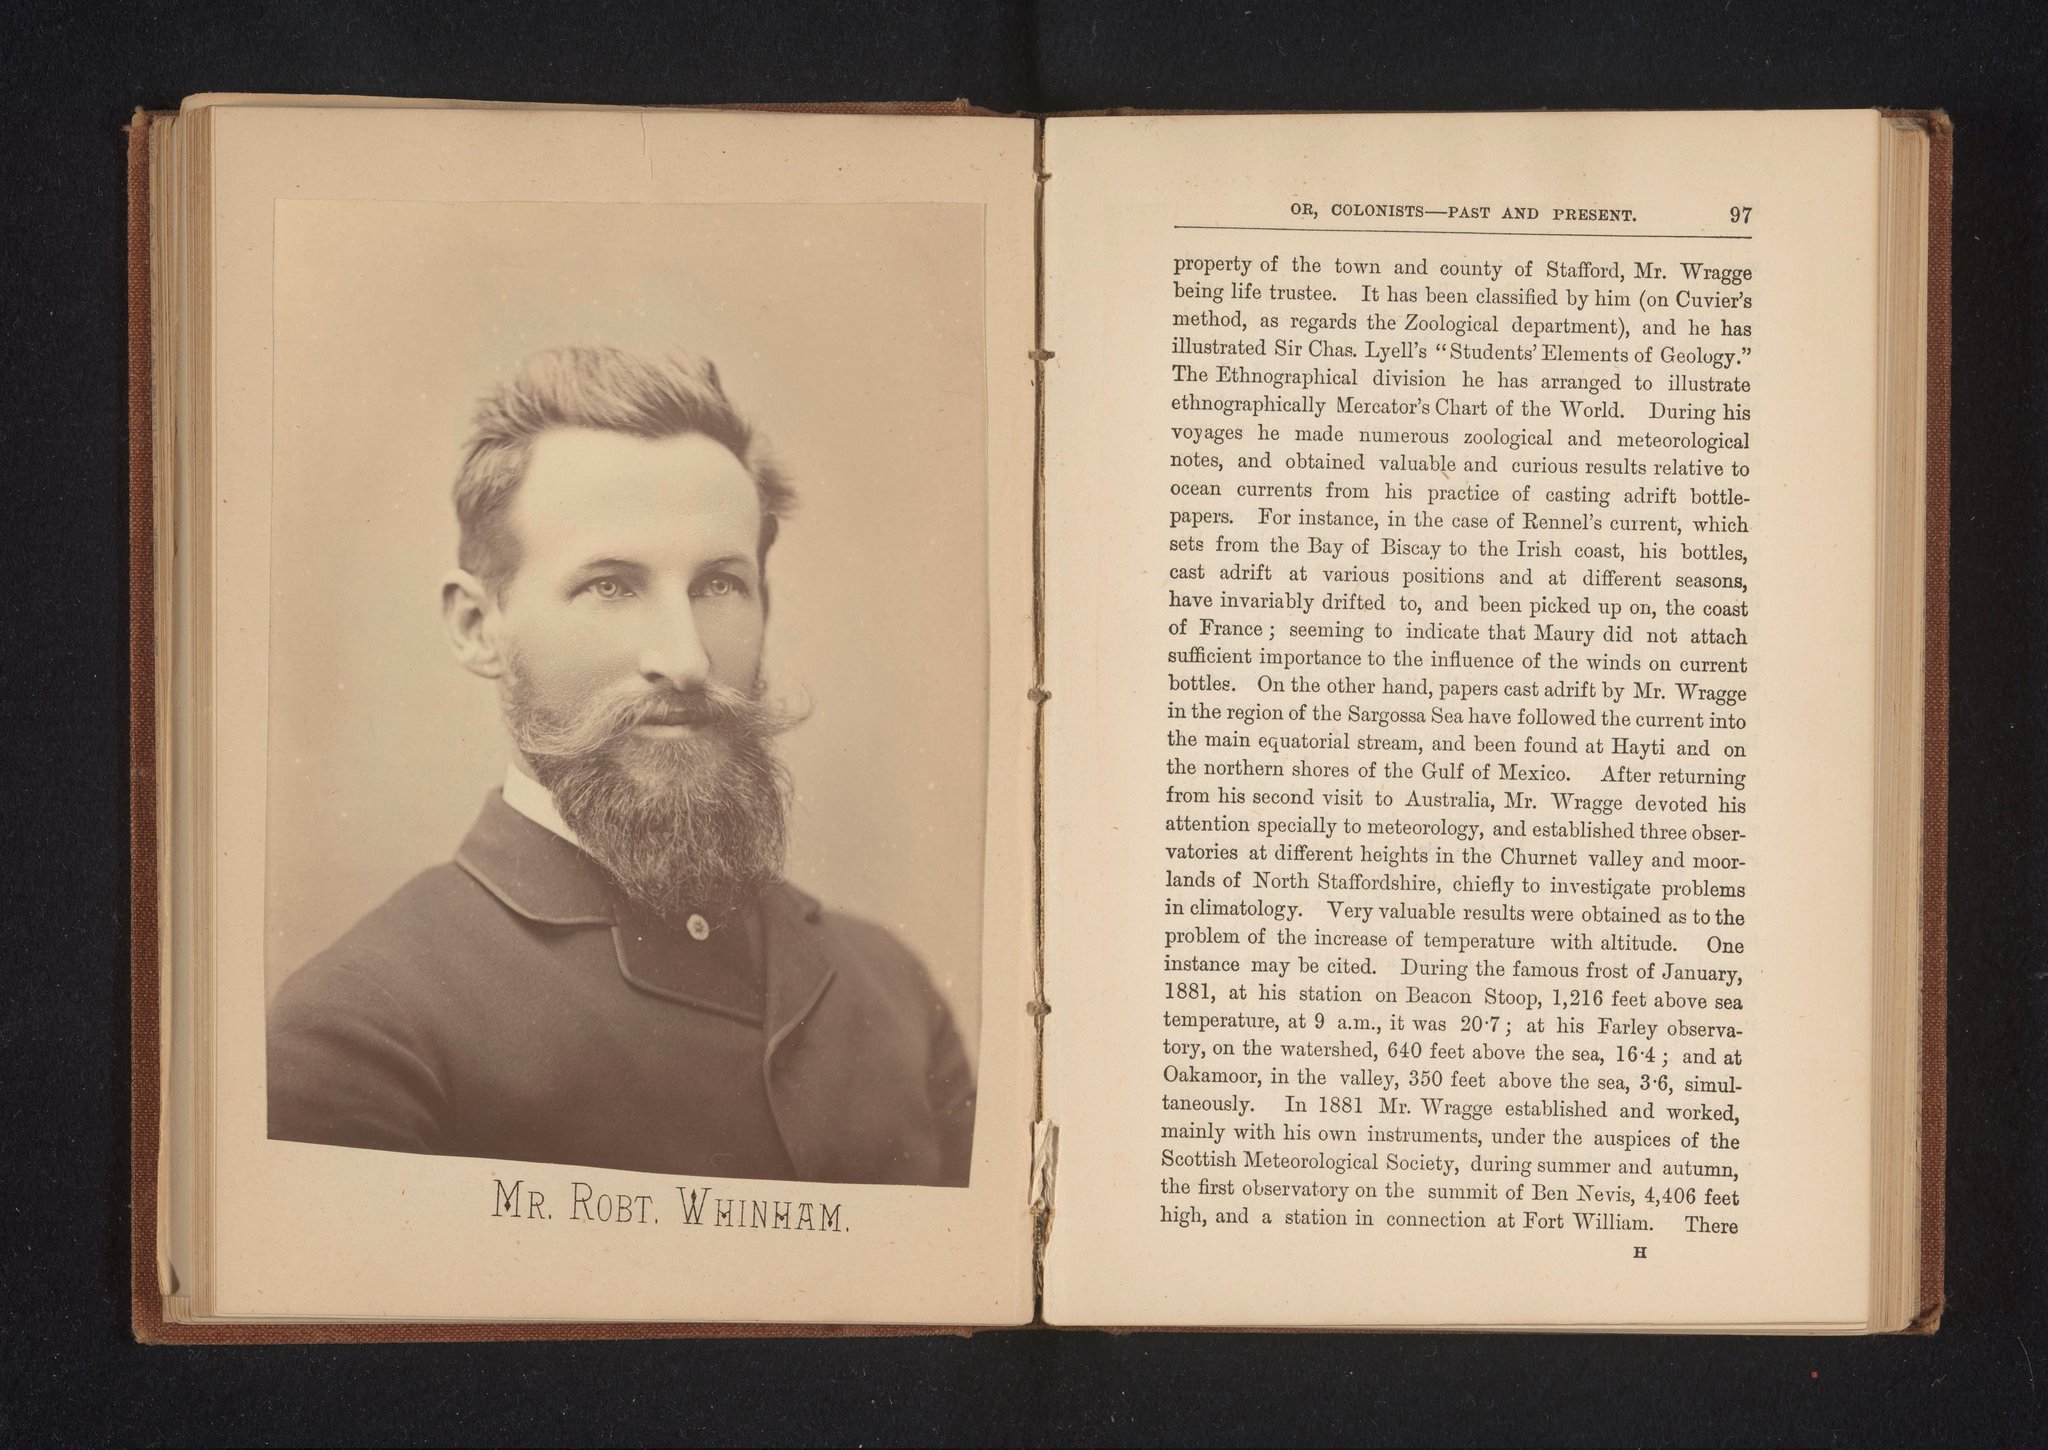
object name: photograph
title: Mr. Robt. Whinham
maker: Anonymous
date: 1875-1885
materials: photographic support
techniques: albumen print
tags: historical persons